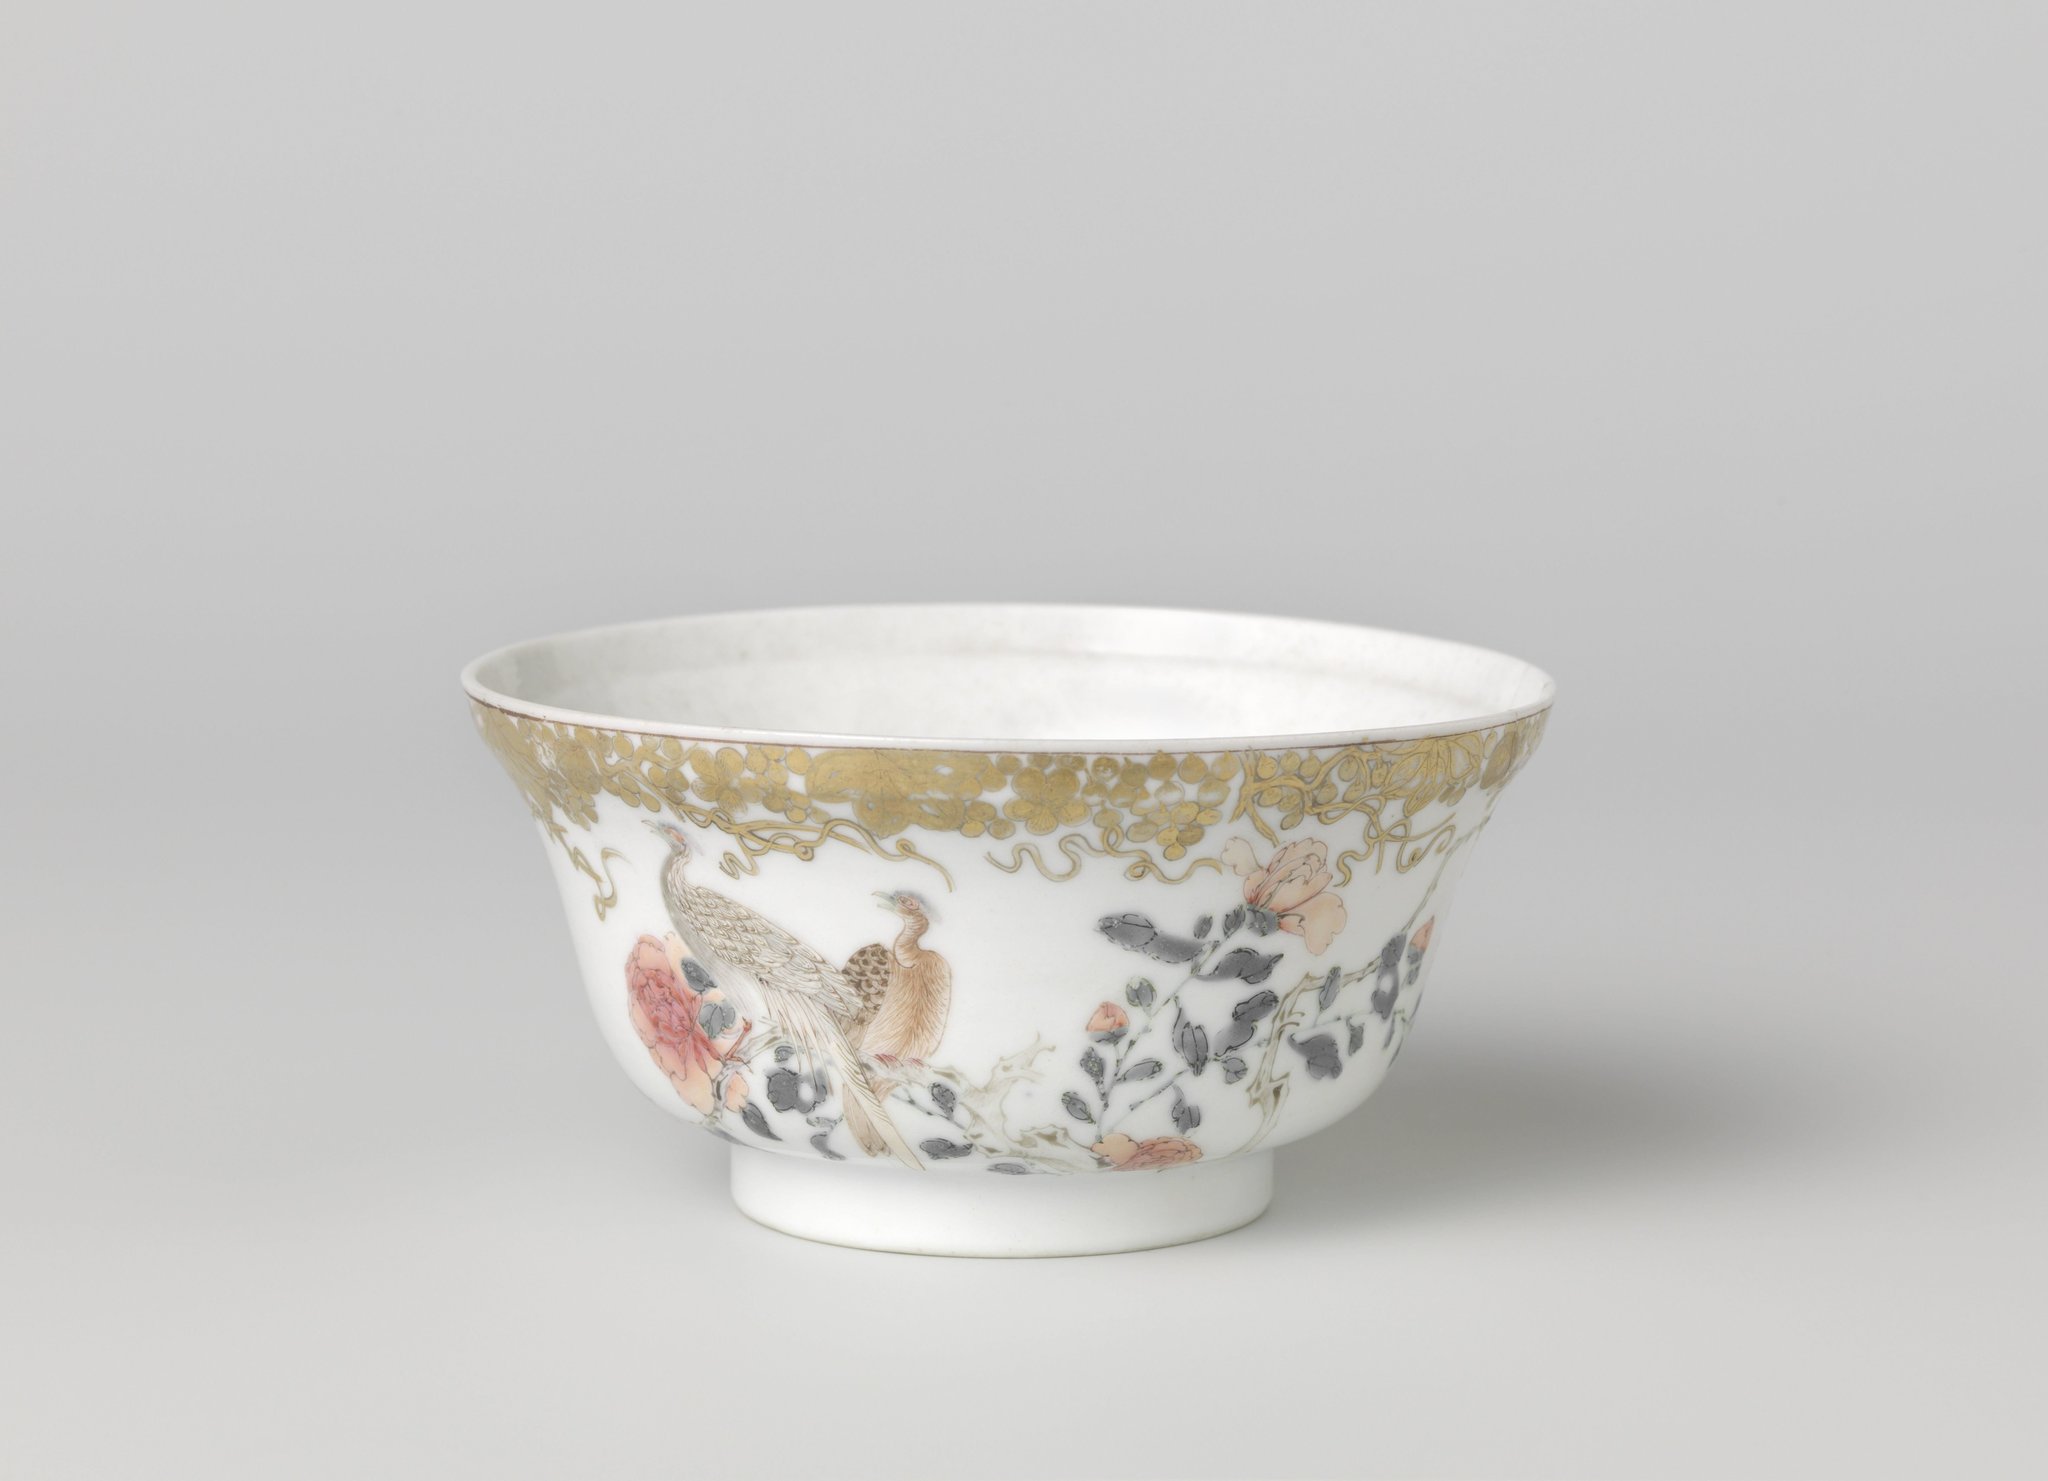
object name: cup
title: Bell-shaped cup with pheasants, peony and vines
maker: Anonymous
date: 1725-1749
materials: glaze, paint, porcelain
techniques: firing, gilding, turning, vitrification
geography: china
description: Kop, versierd met gouden rand en bloemen in kleuren.